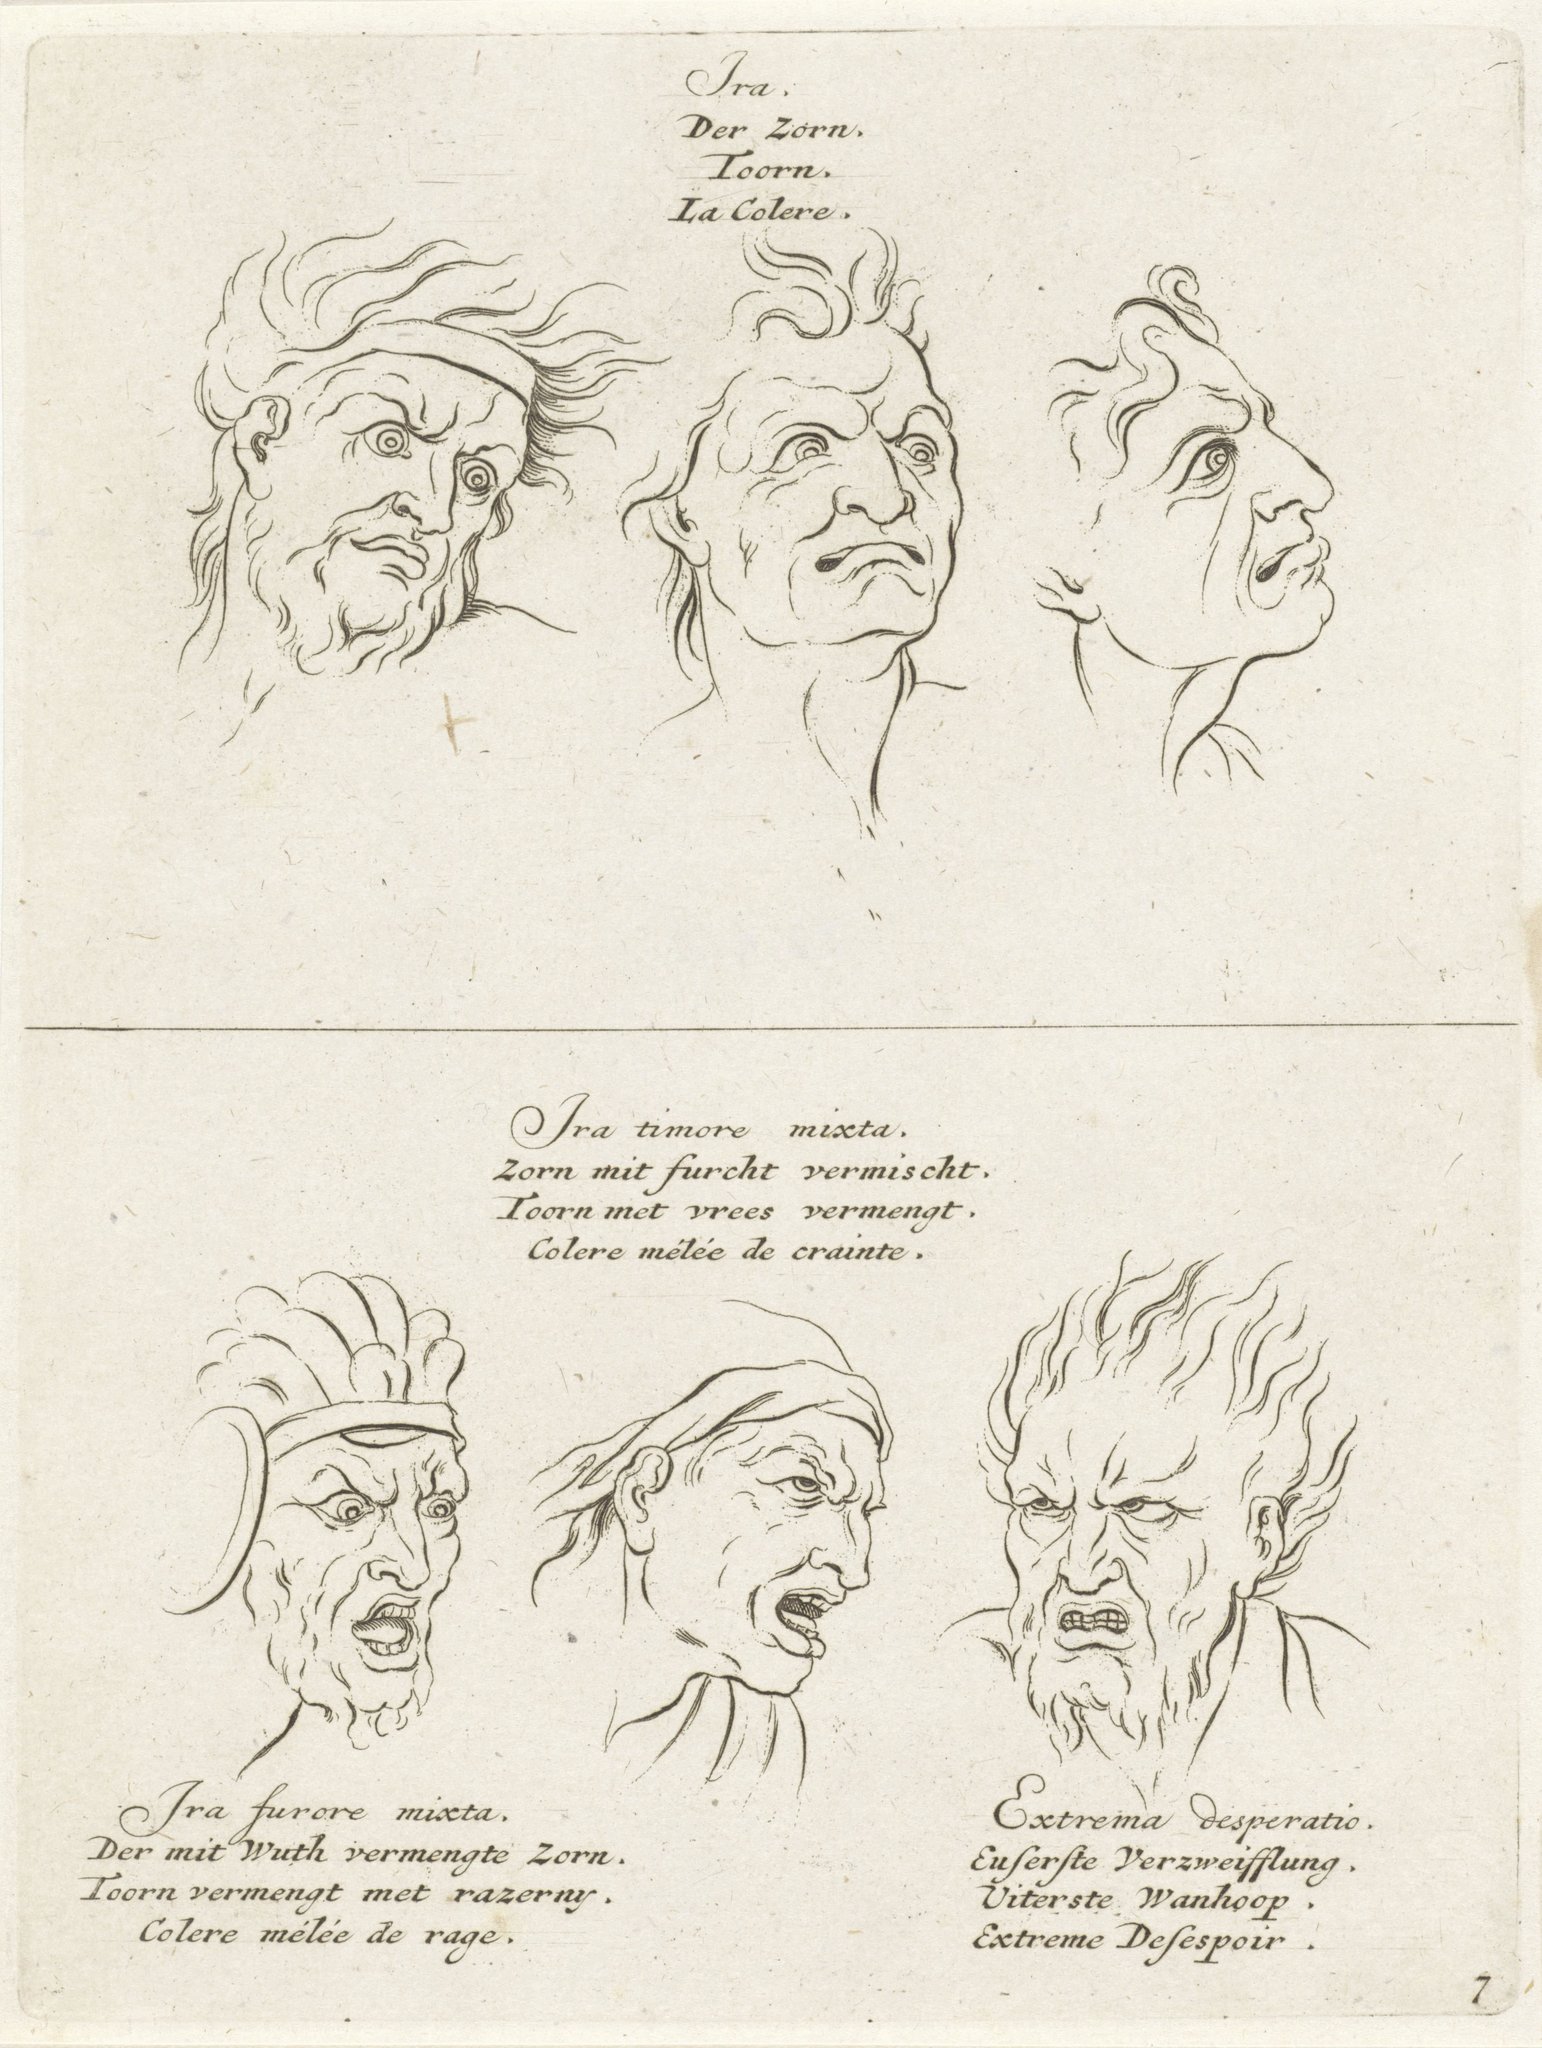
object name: print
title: Aftekening en verbeelding der hartstogten / Abbild oder Vorstellung der Gemühts regungen/ Effigies et Repraesentatio Affectionum animi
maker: pieter schenk (i)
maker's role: print maker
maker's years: 1660-1711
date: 1692-1711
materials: paper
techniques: etching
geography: amsterdam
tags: morphology of facial expression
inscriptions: collector's mark: Lugt 2233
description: Bovenaan een twee gezichten van voren en een van opzij met een vertoornde gezichtsuitdrukking. Onderaan drie gezichten. De eerste met een uitdrukking van woede en toorn, de tweede met een uitdrukking van toorn en vrees en de derde met een uitdrukking van uiterste wanhoop.